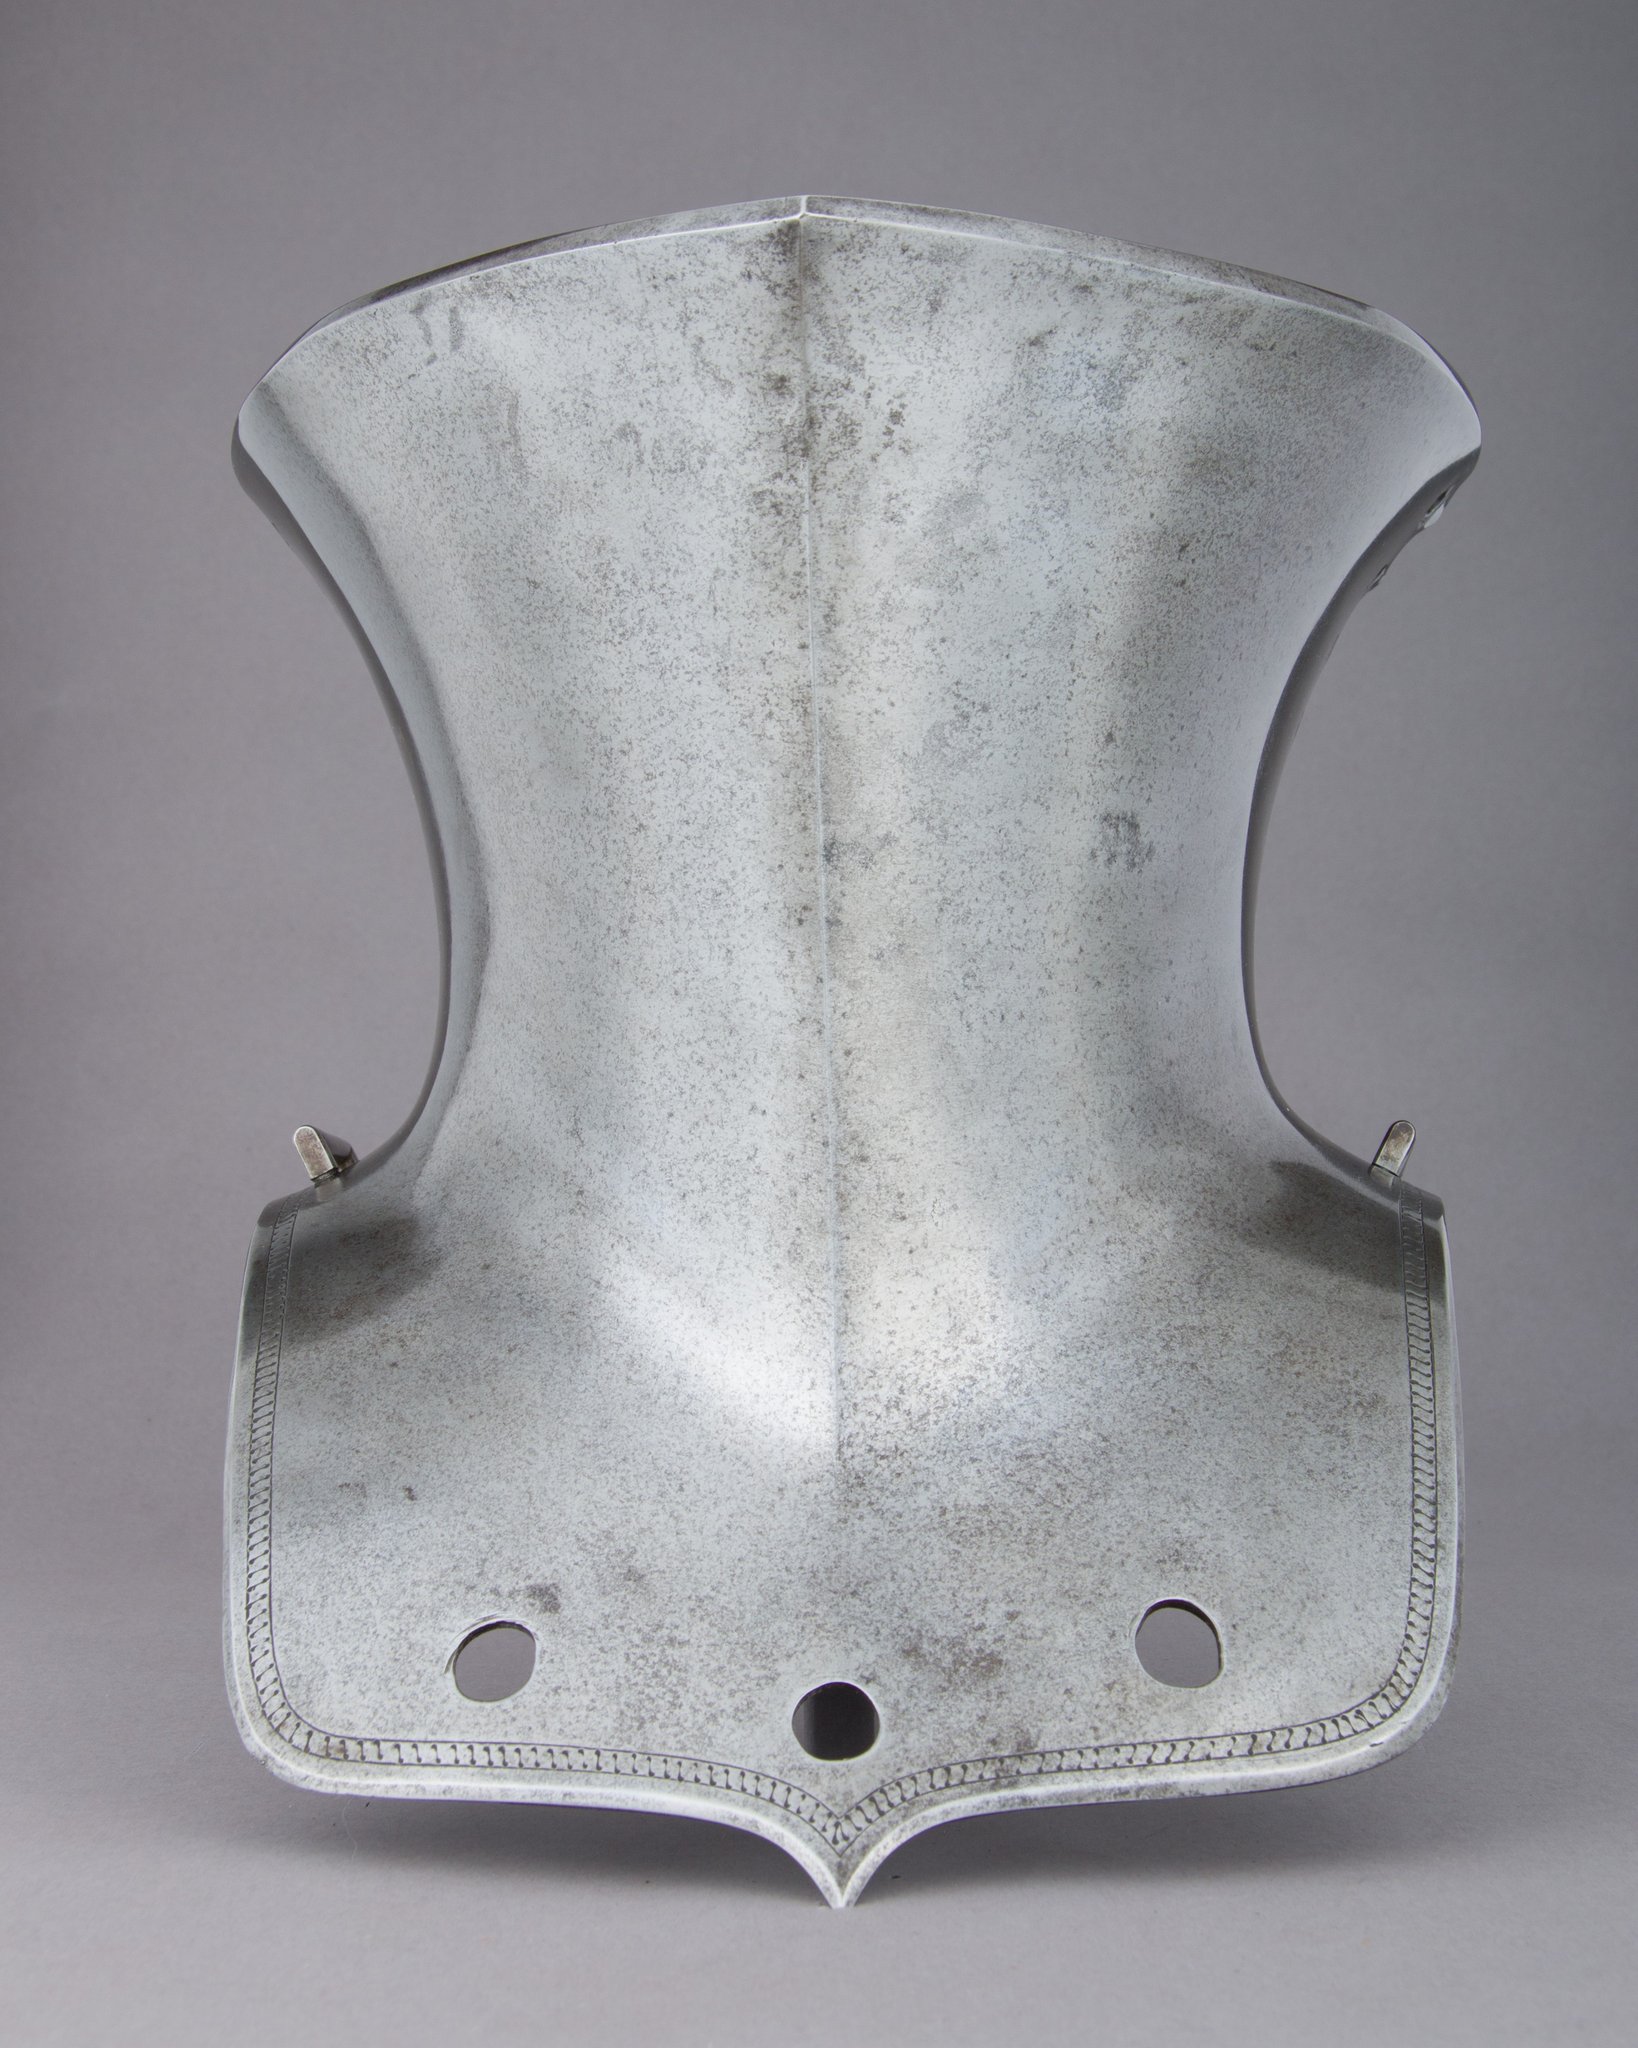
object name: frontal plate from a tilting heaume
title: Frontal Plate from a Tilting Heaume in French or German Style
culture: french or german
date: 1850-1900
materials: steel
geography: france or germany